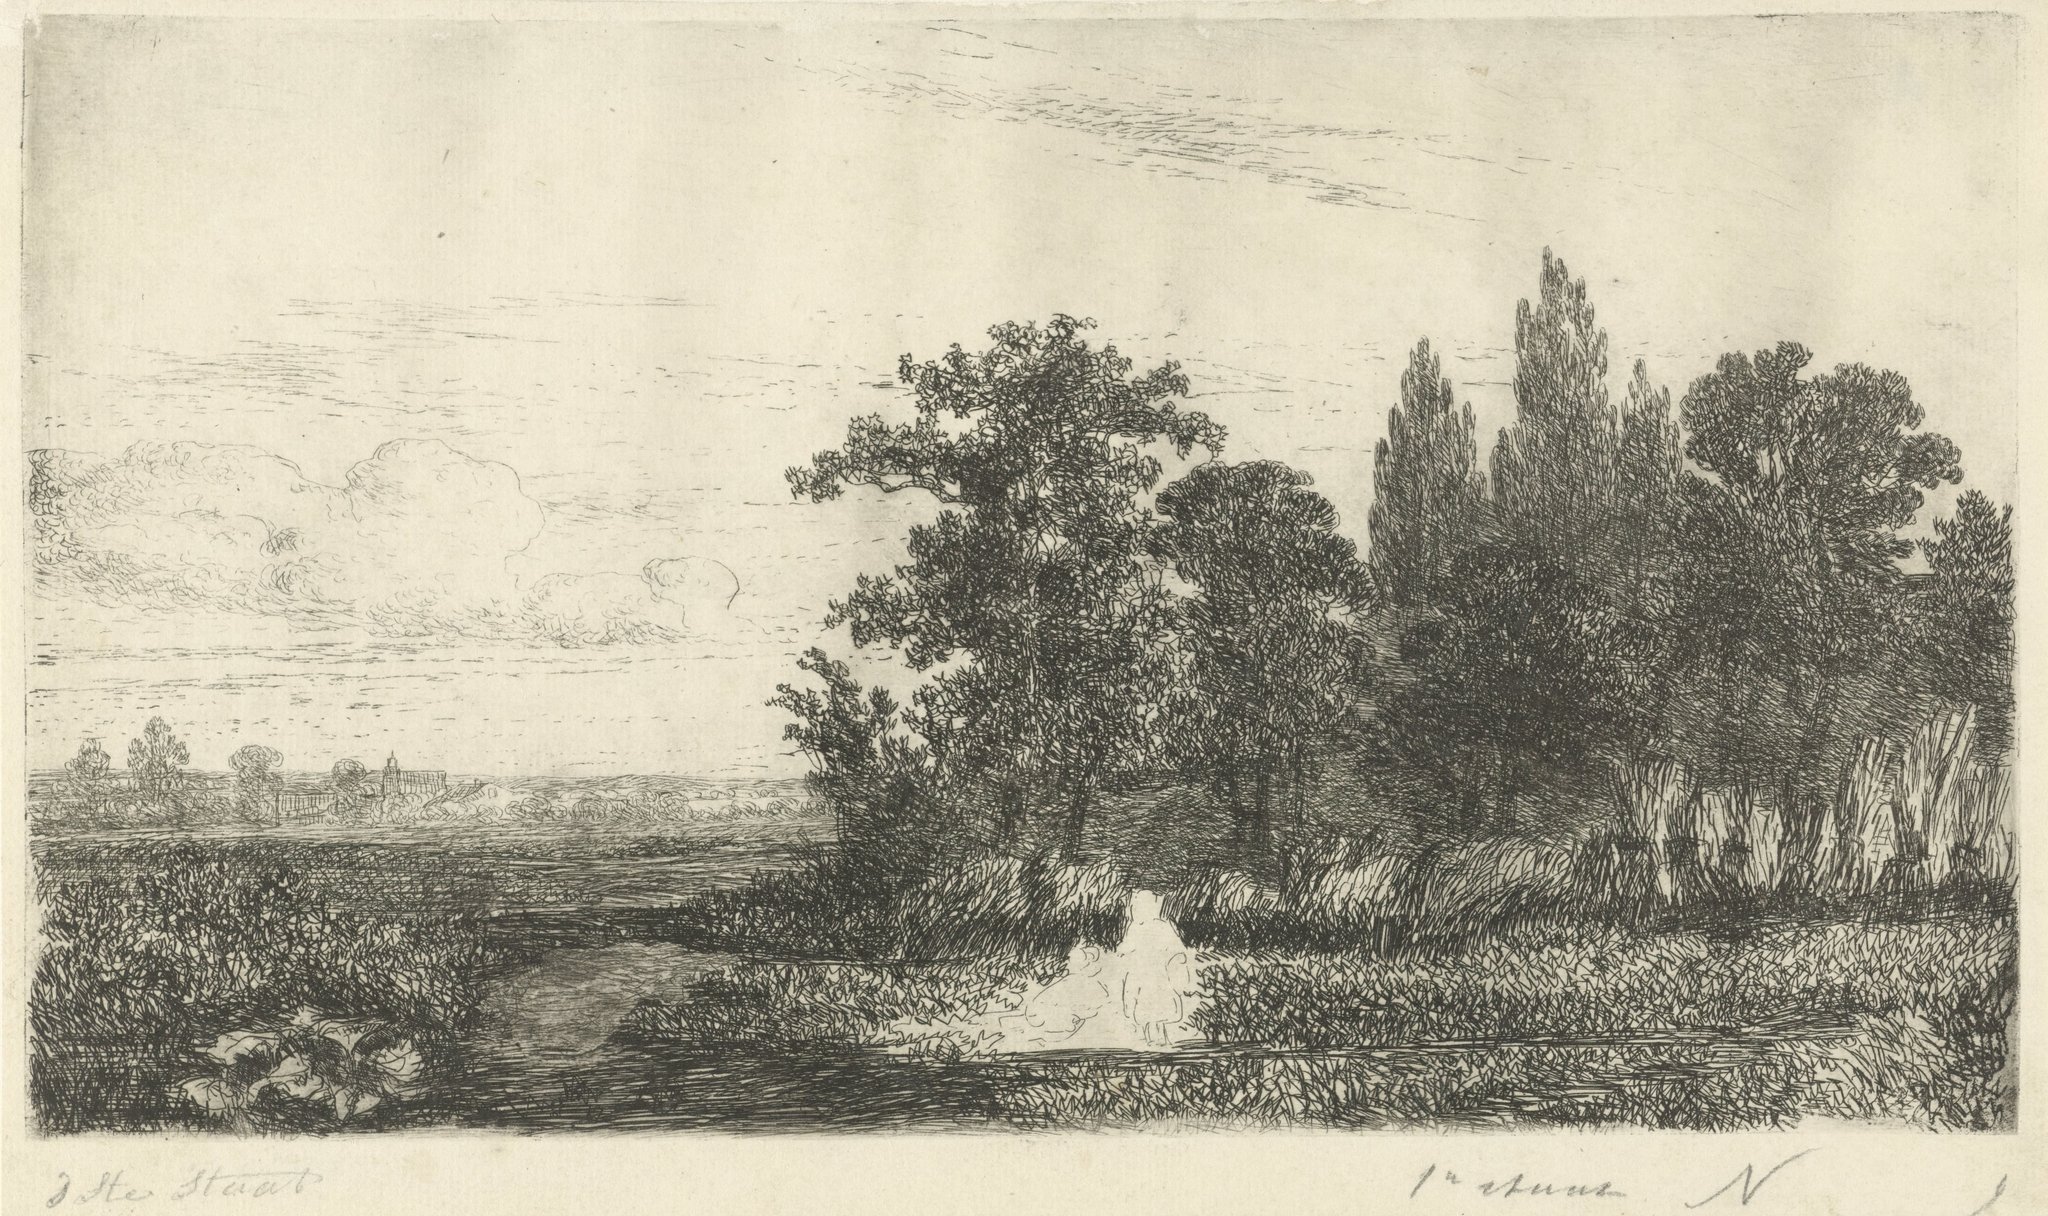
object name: print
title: Man en vrouw bij een beekje aan de bosrand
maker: hermanus jan hendrik van rijkelijkhuysen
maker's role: painter, print maker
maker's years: 1813-1883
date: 1857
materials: paper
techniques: drypoint, etching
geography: utrecht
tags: church (exterior), forest, wood, brook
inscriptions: collector's mark: Lugt 2228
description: Gezicht op de rand van een bos, waar zich bij een beekje een man en een vrouw bevinden. De man zit en de vrouw staat. Op de achtergrond de contouren van een kerk.